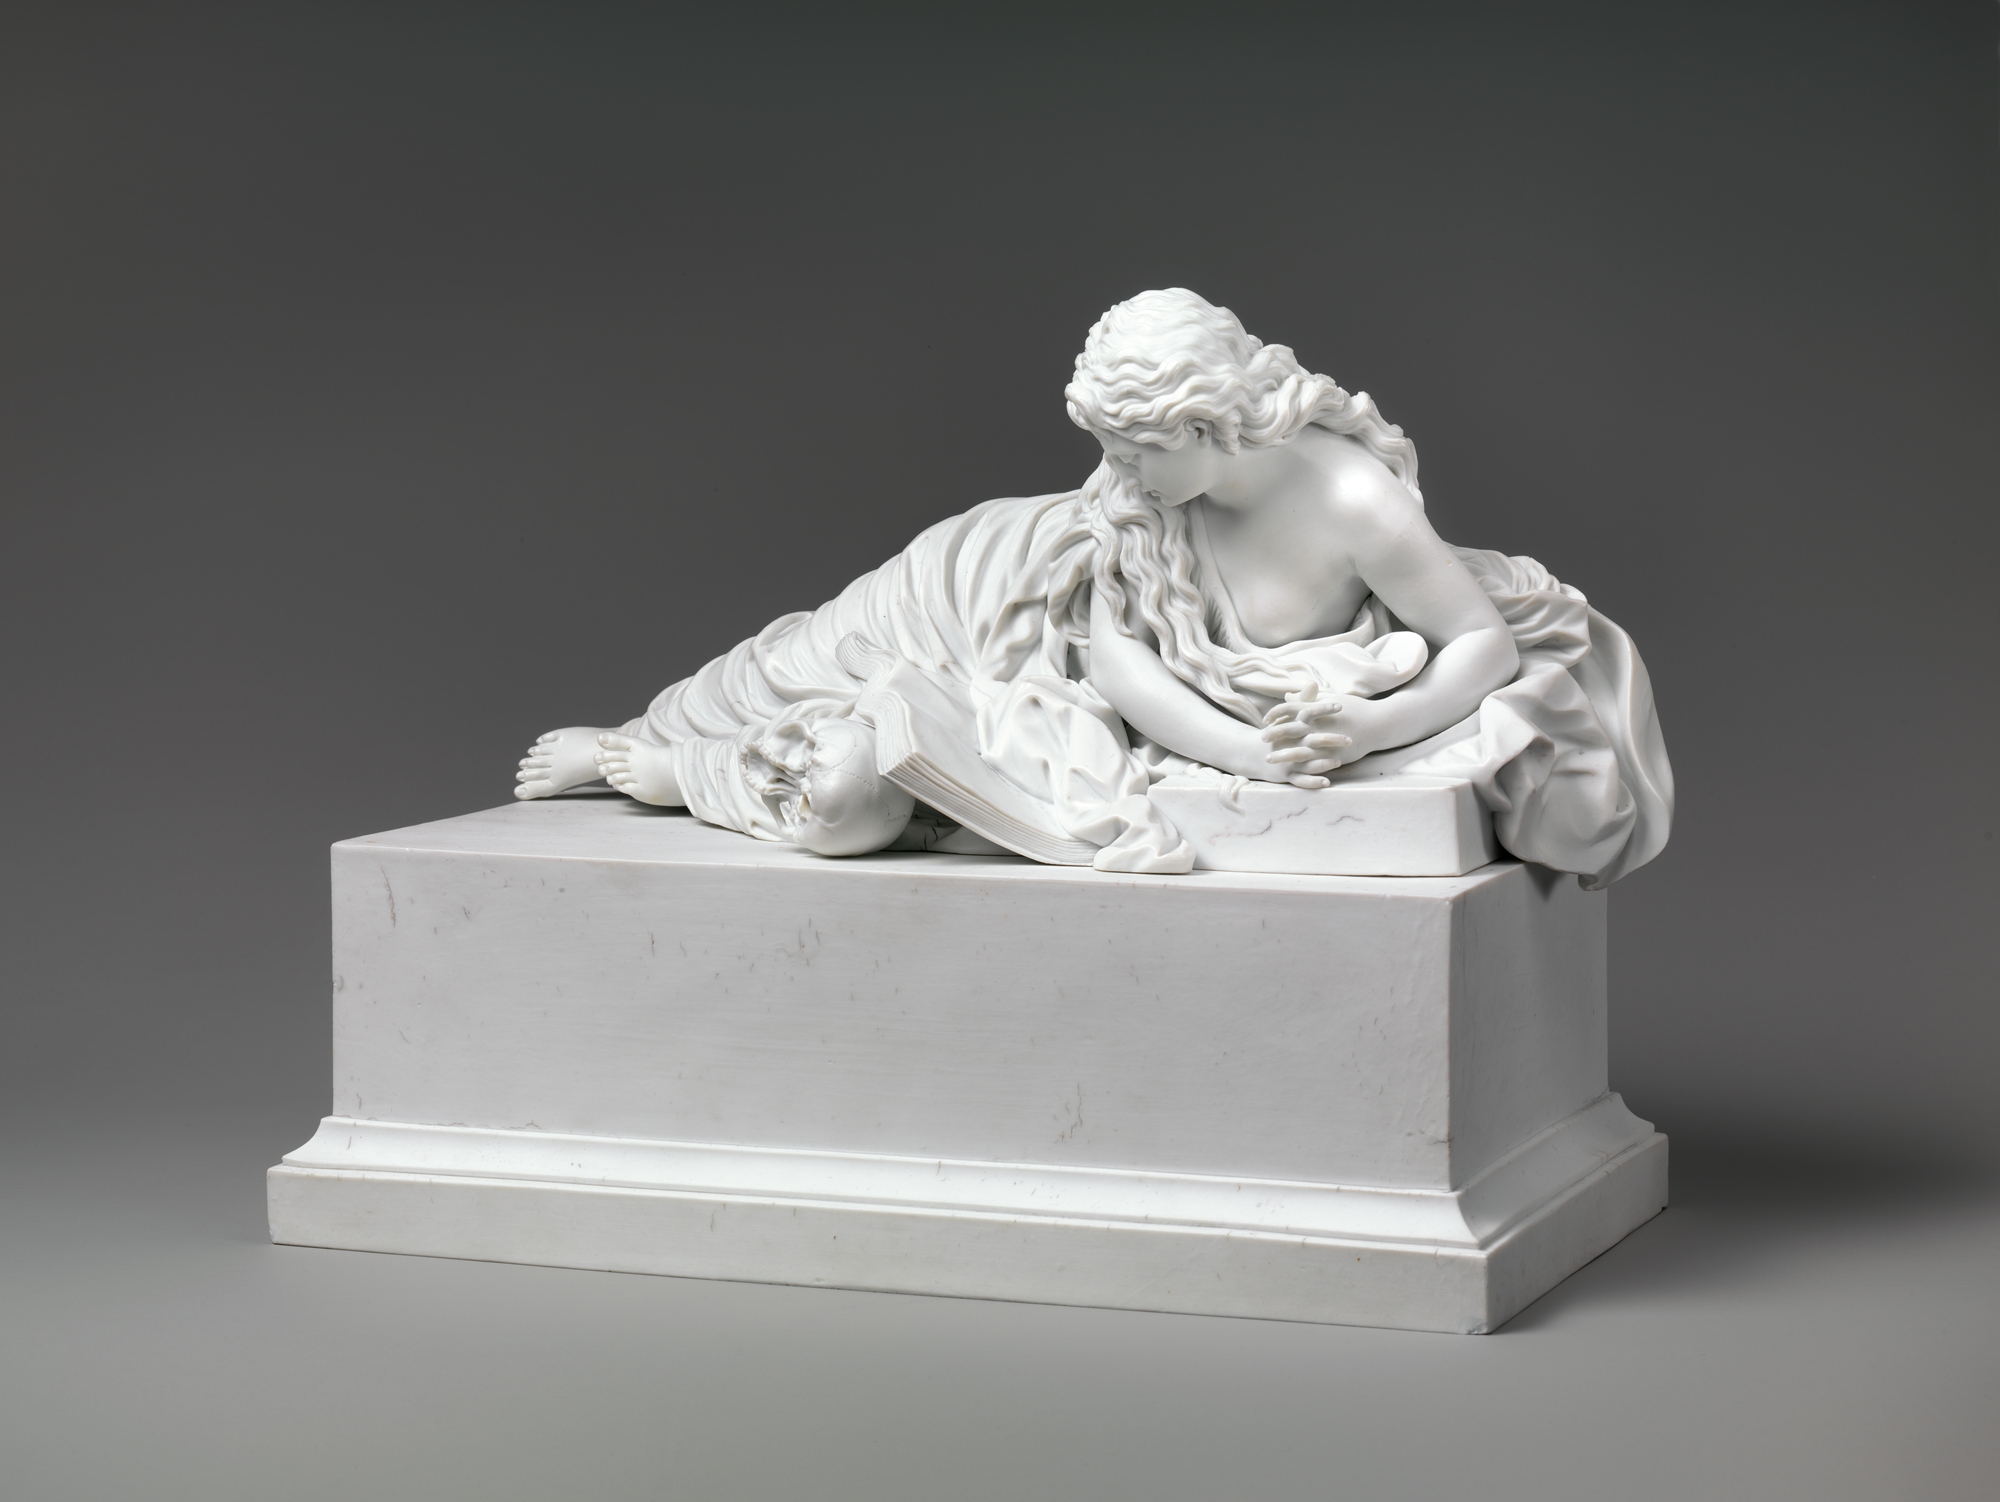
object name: figure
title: The Penitent Magdalene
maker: meissen manufactory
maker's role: manufactory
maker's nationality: german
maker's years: 1710-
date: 1783-1790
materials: biscuit, paste, porcelain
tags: mary magdalene